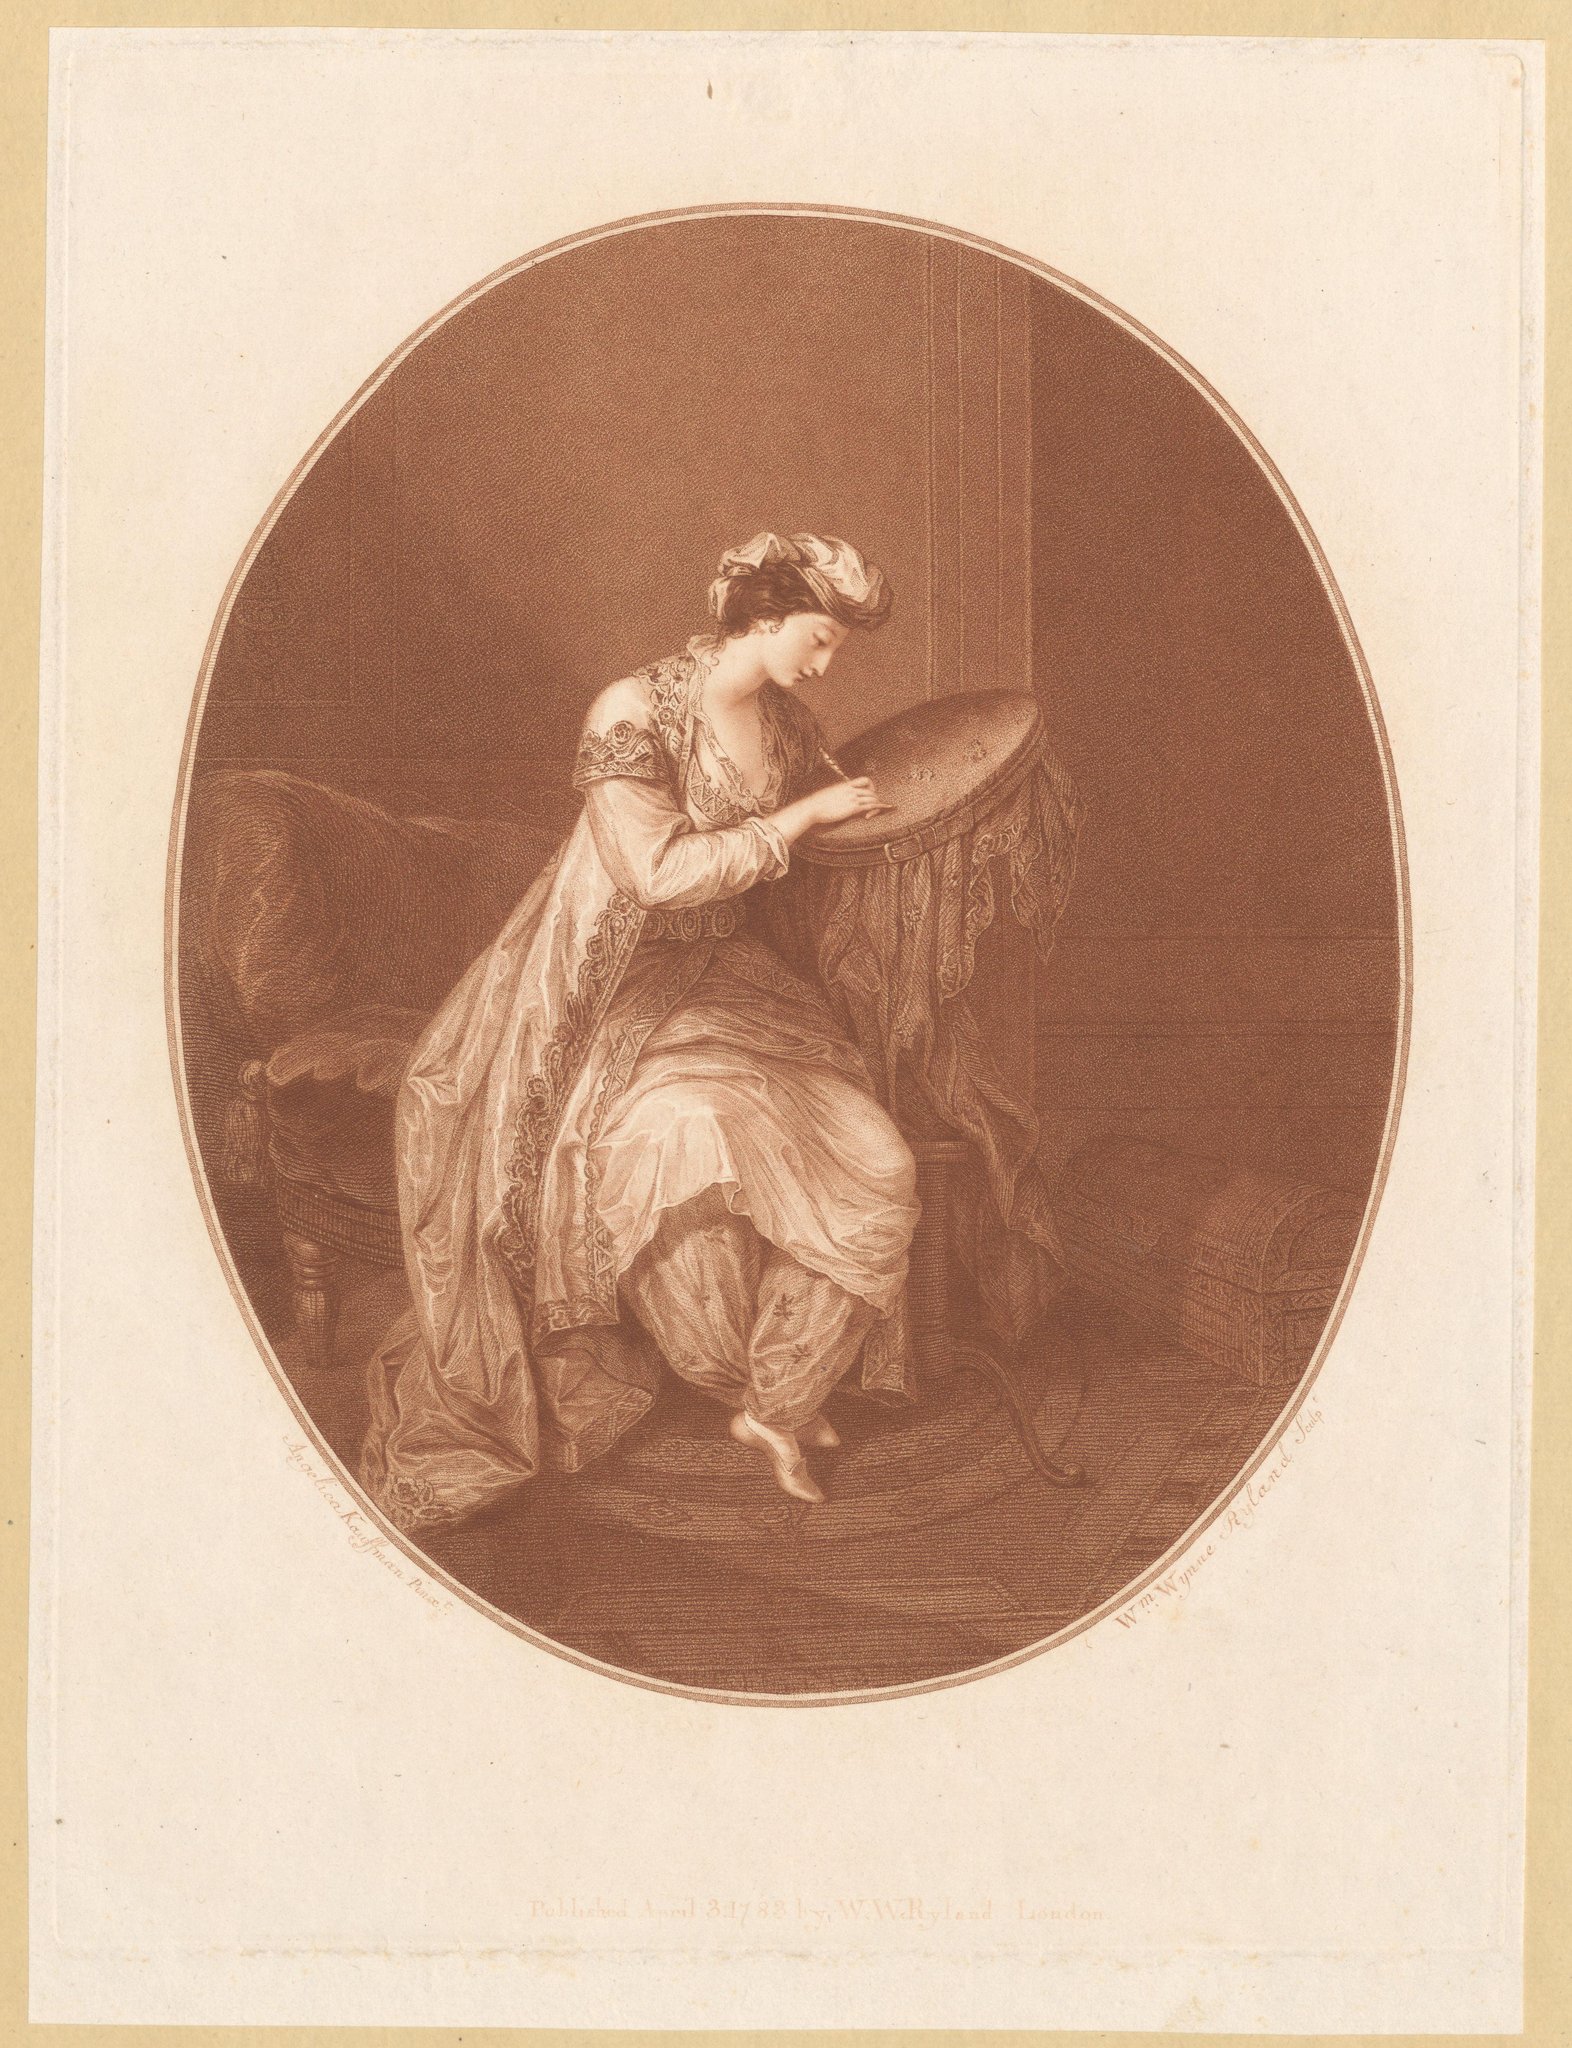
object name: print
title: Bordurende vrouw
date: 1783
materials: paper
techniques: etching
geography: london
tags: embroidering ~ textile industry, adolescent, young woman, maiden